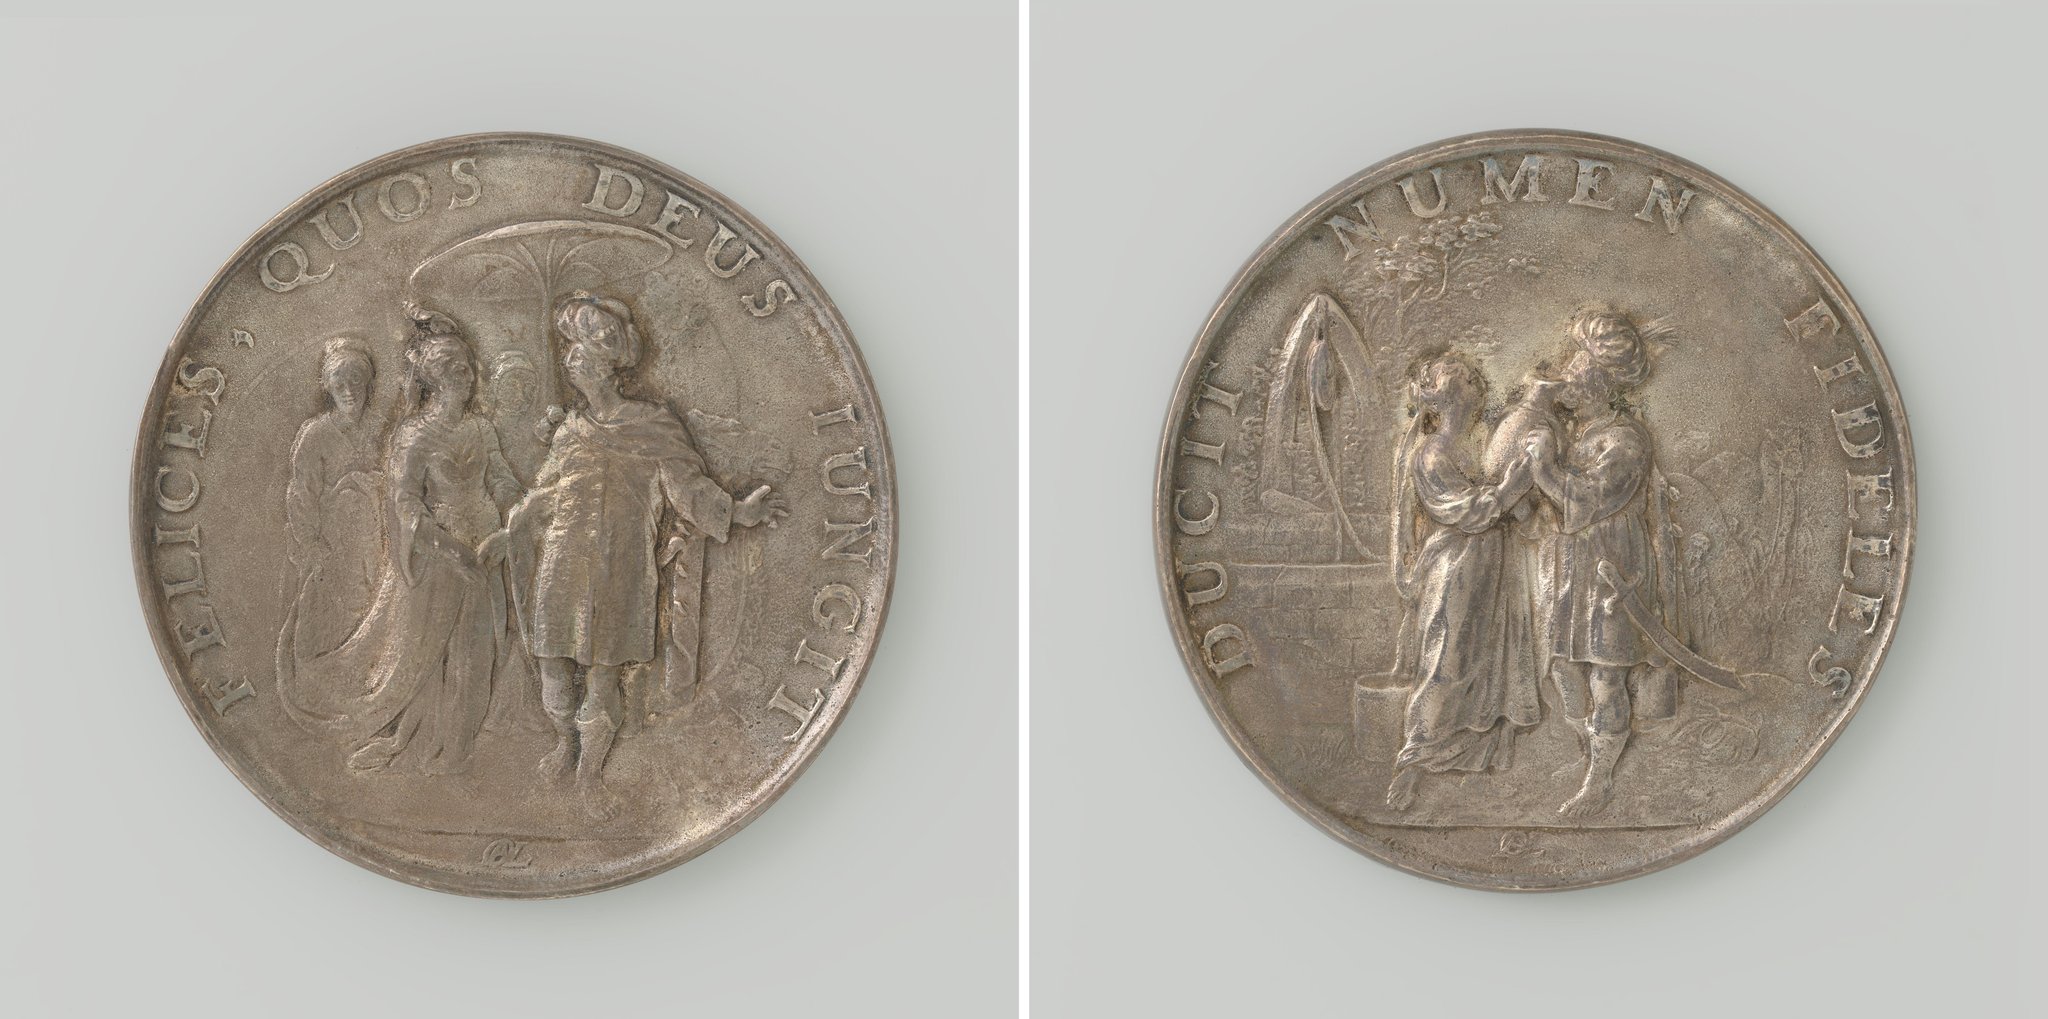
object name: marriage medal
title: Rebecca at the Well and the Meeting of Rebecca and Isaac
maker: johannes lutma (1624-1689)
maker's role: print maker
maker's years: 1624-1689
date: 1654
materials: silver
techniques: casting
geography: amsterdam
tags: marriage of isaac and rebekah, the meeting at the well: eliezer sees rebekah coming with a pitcher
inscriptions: monogram: ‘IOAL F’, edge inscription: ‘DUCIT NUMEN FIDELIS’, edge inscription: ‘FELICES QUOS DEUS IUNGIT’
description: Lutma was famous for his history scenes in silver, which could rival painted images. He suggested figures emerging out of the dark by partially roughening the surface. The scenes represented here are metaphors for marriage. The image of Rebecca at the well stood for a wife’s obedience to her husband. In the meeting of Rebecca and Isaac, she symbolizes conjugal bliss.